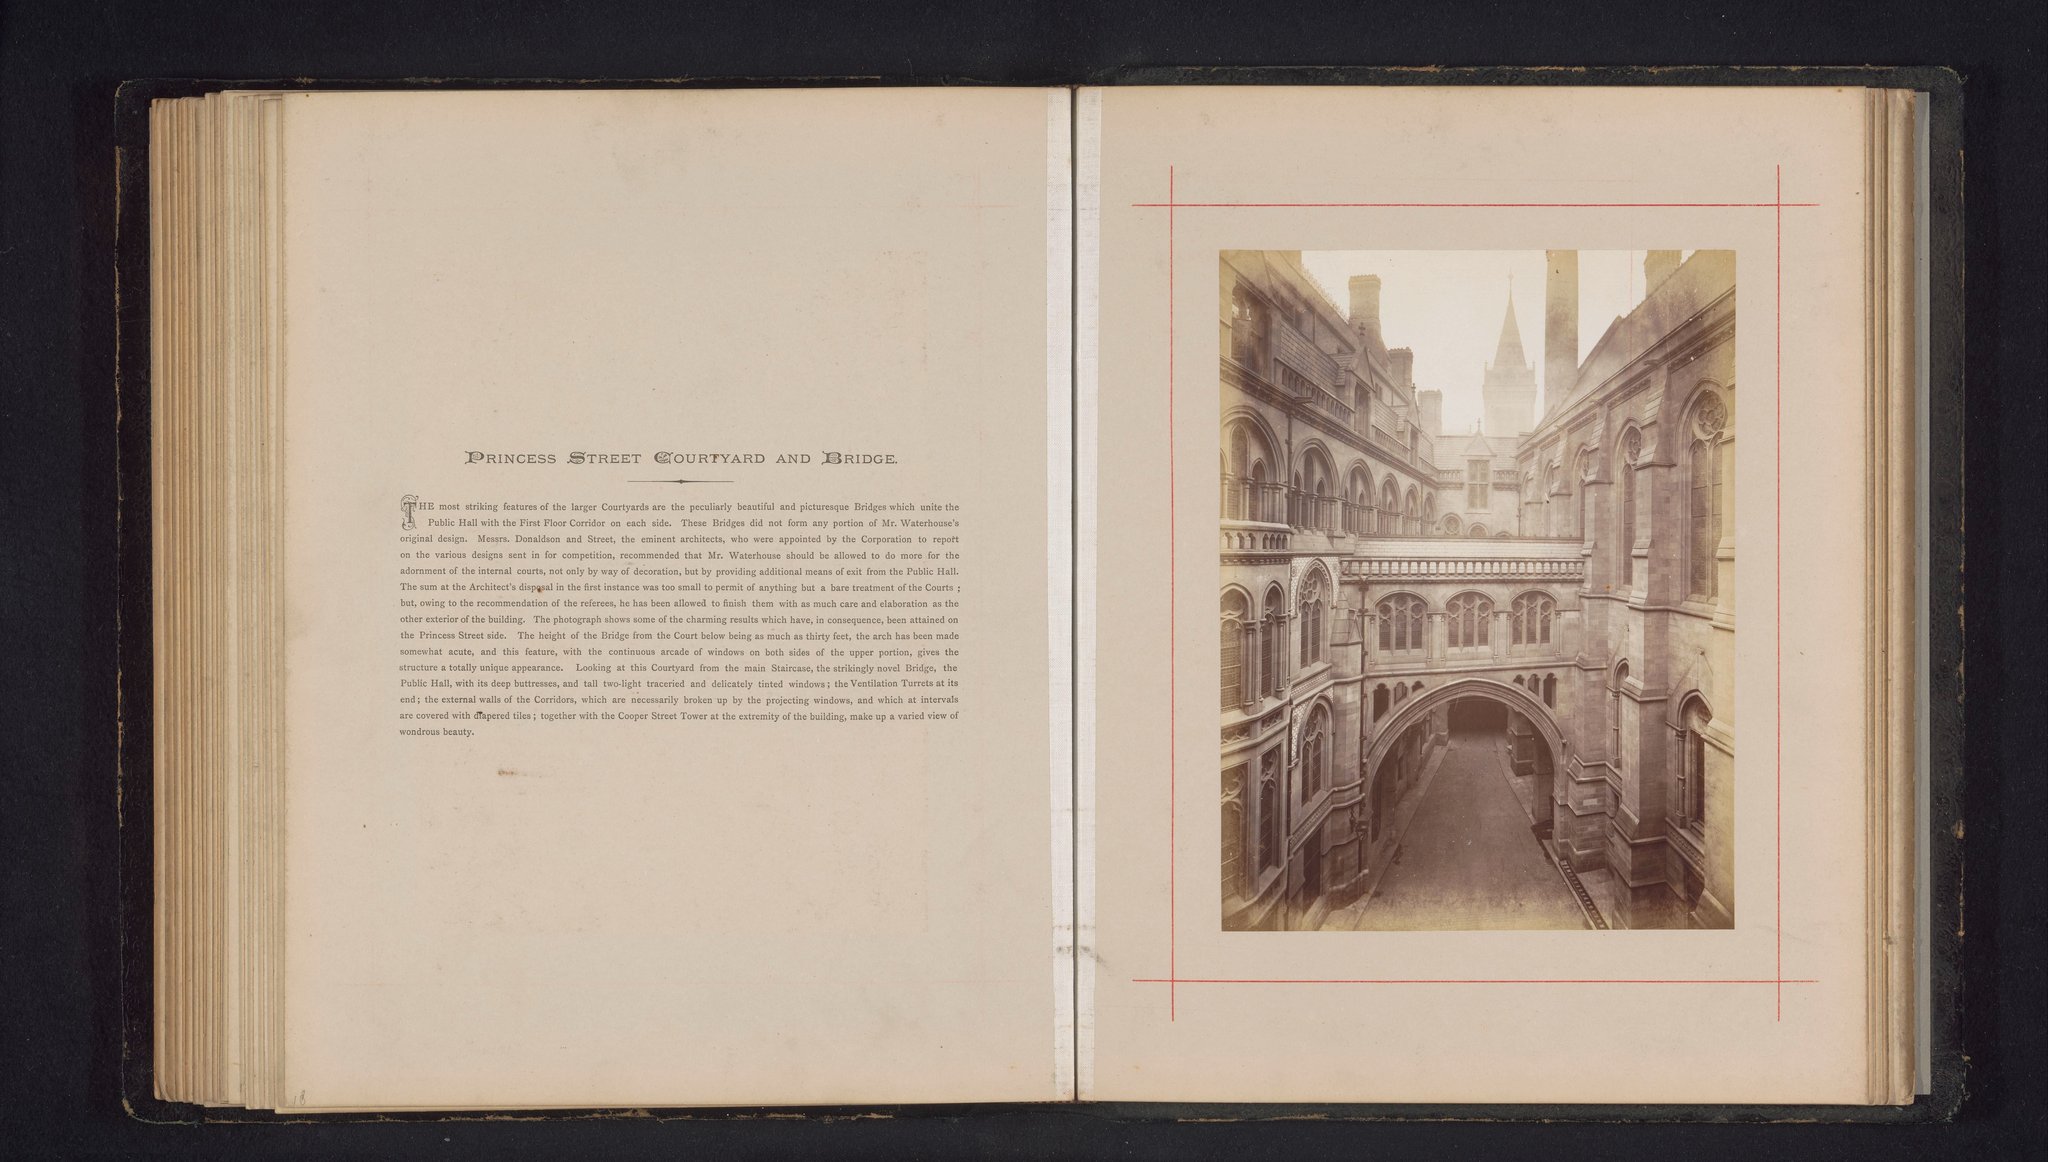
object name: photograph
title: Binnenhof van het Stadhuis van Manchester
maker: j. mcleod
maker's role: fotograaf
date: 1877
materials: photographic support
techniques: albumen print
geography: manchester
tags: townhall, courtyard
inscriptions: title: ‘Princess Street Courtyard and Bridge’